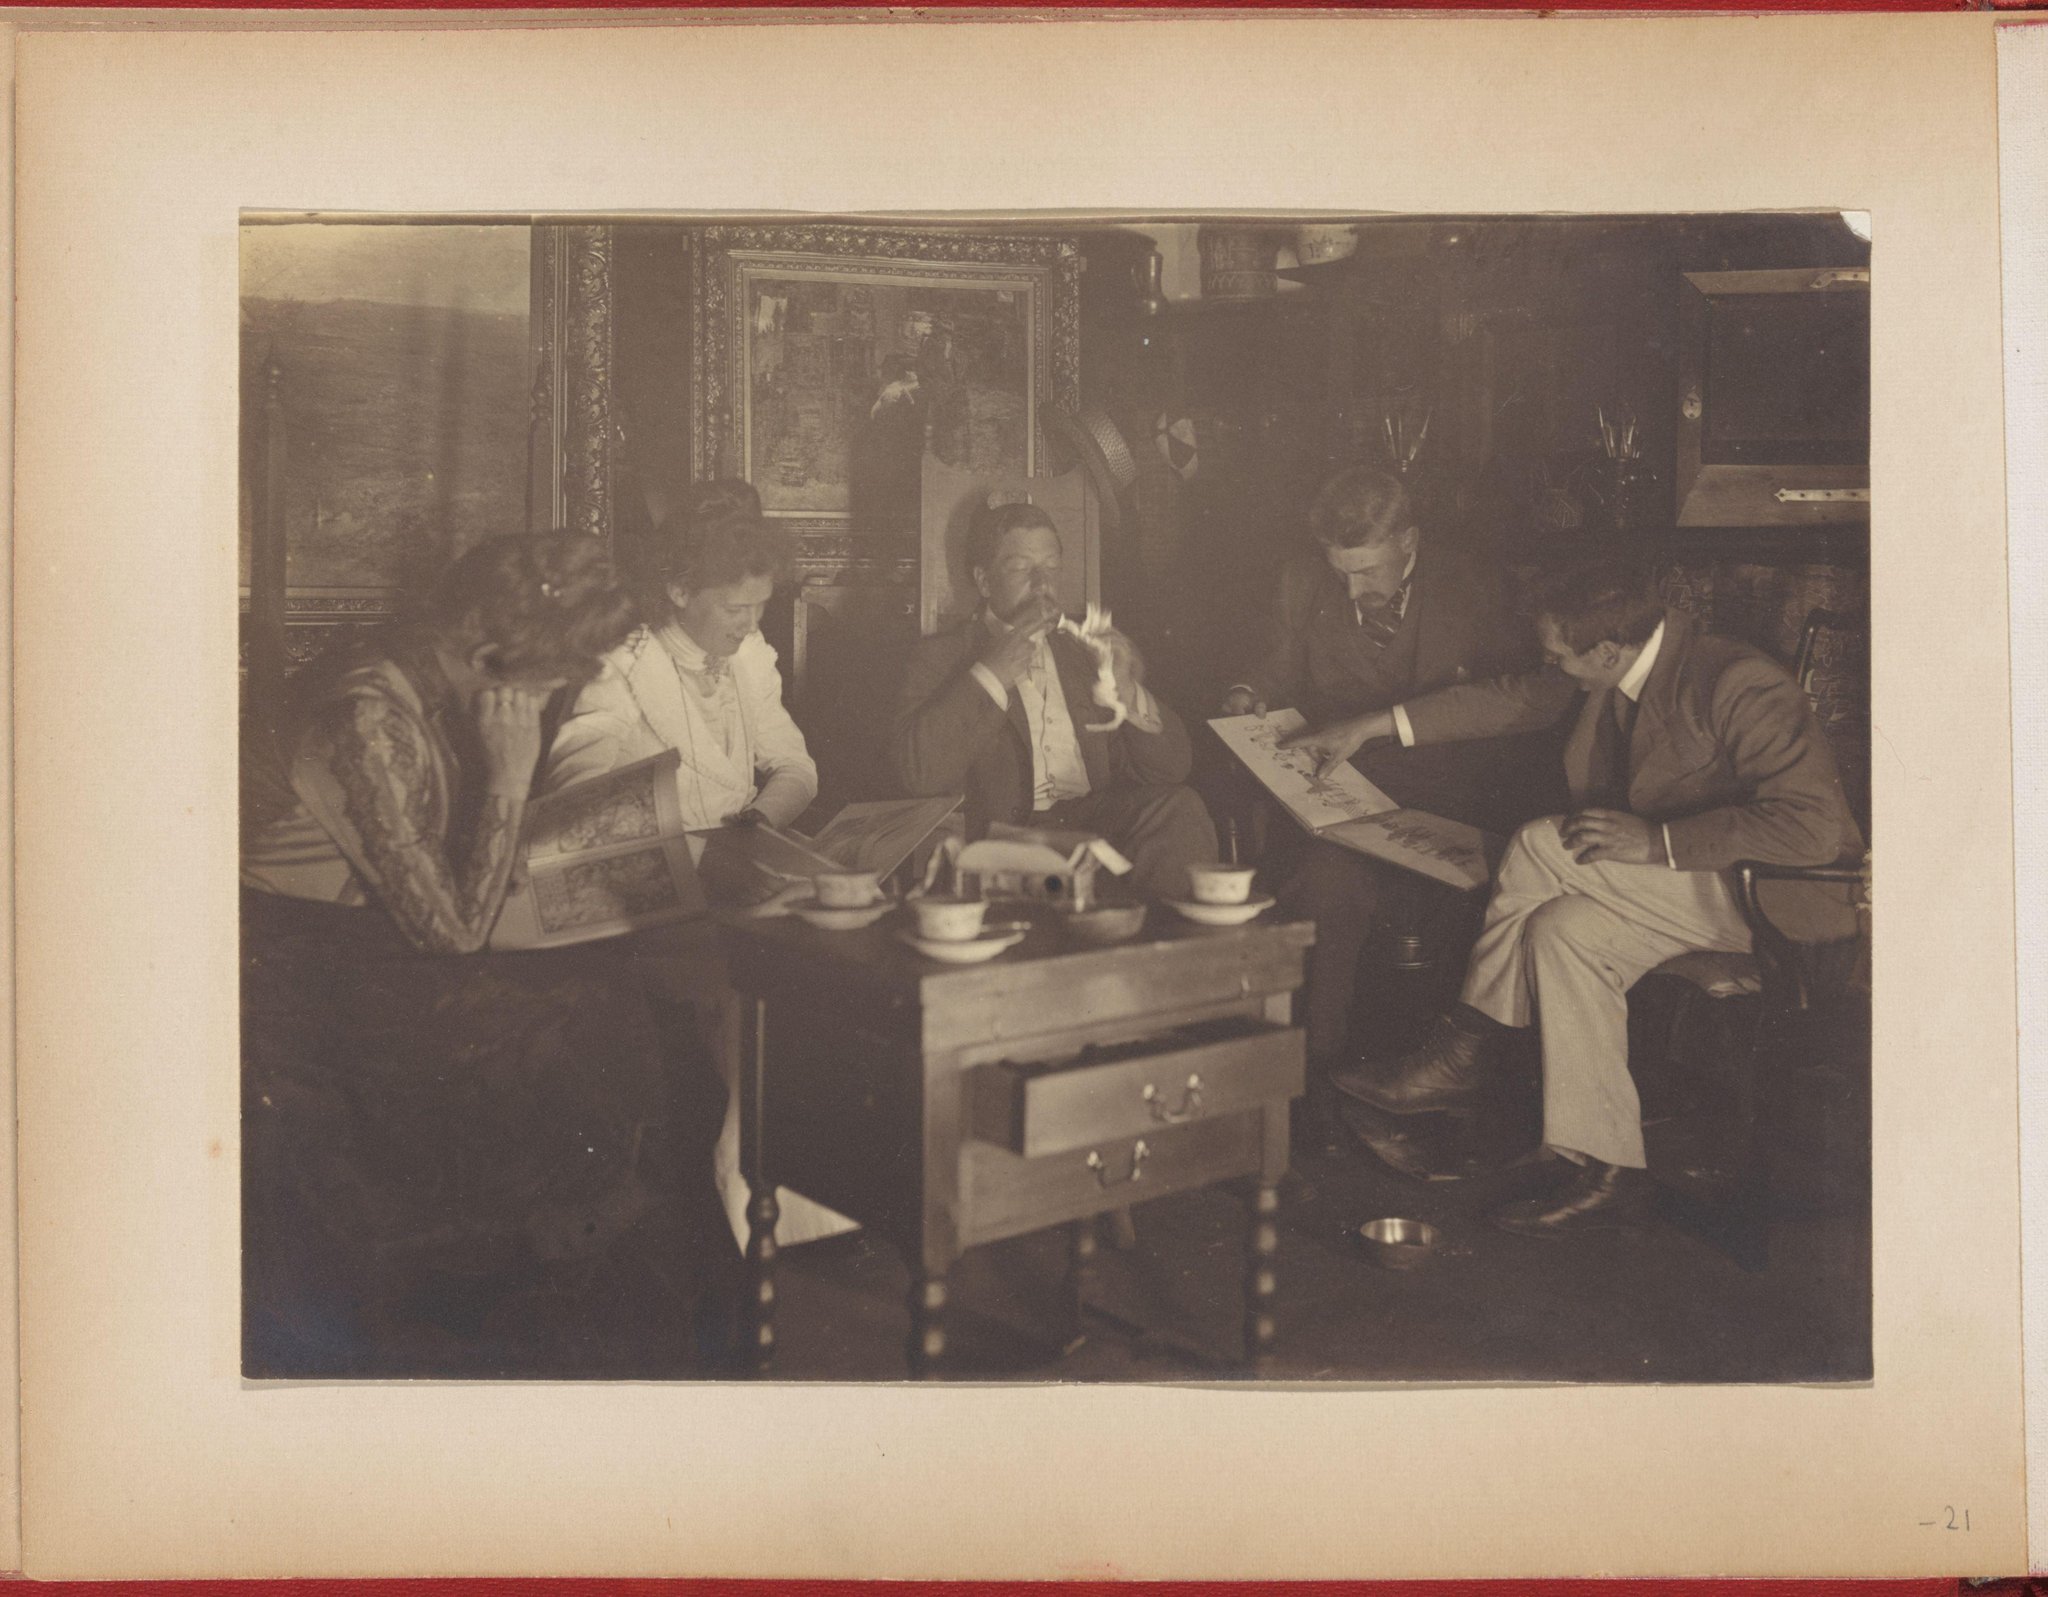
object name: photograph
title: Hedwig Kleintjes, Gerard Aalbersberg, Jan Kleintjes en een onbekende man en vrouw bekijken een schetsboek in het huis van Kleintjes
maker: gerard aalbersberg (us)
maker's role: amateurfotograaf, arts, chirurg, gynaecoloog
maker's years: 1870-1934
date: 1900-1906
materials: paper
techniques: gelatin silver print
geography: heerde